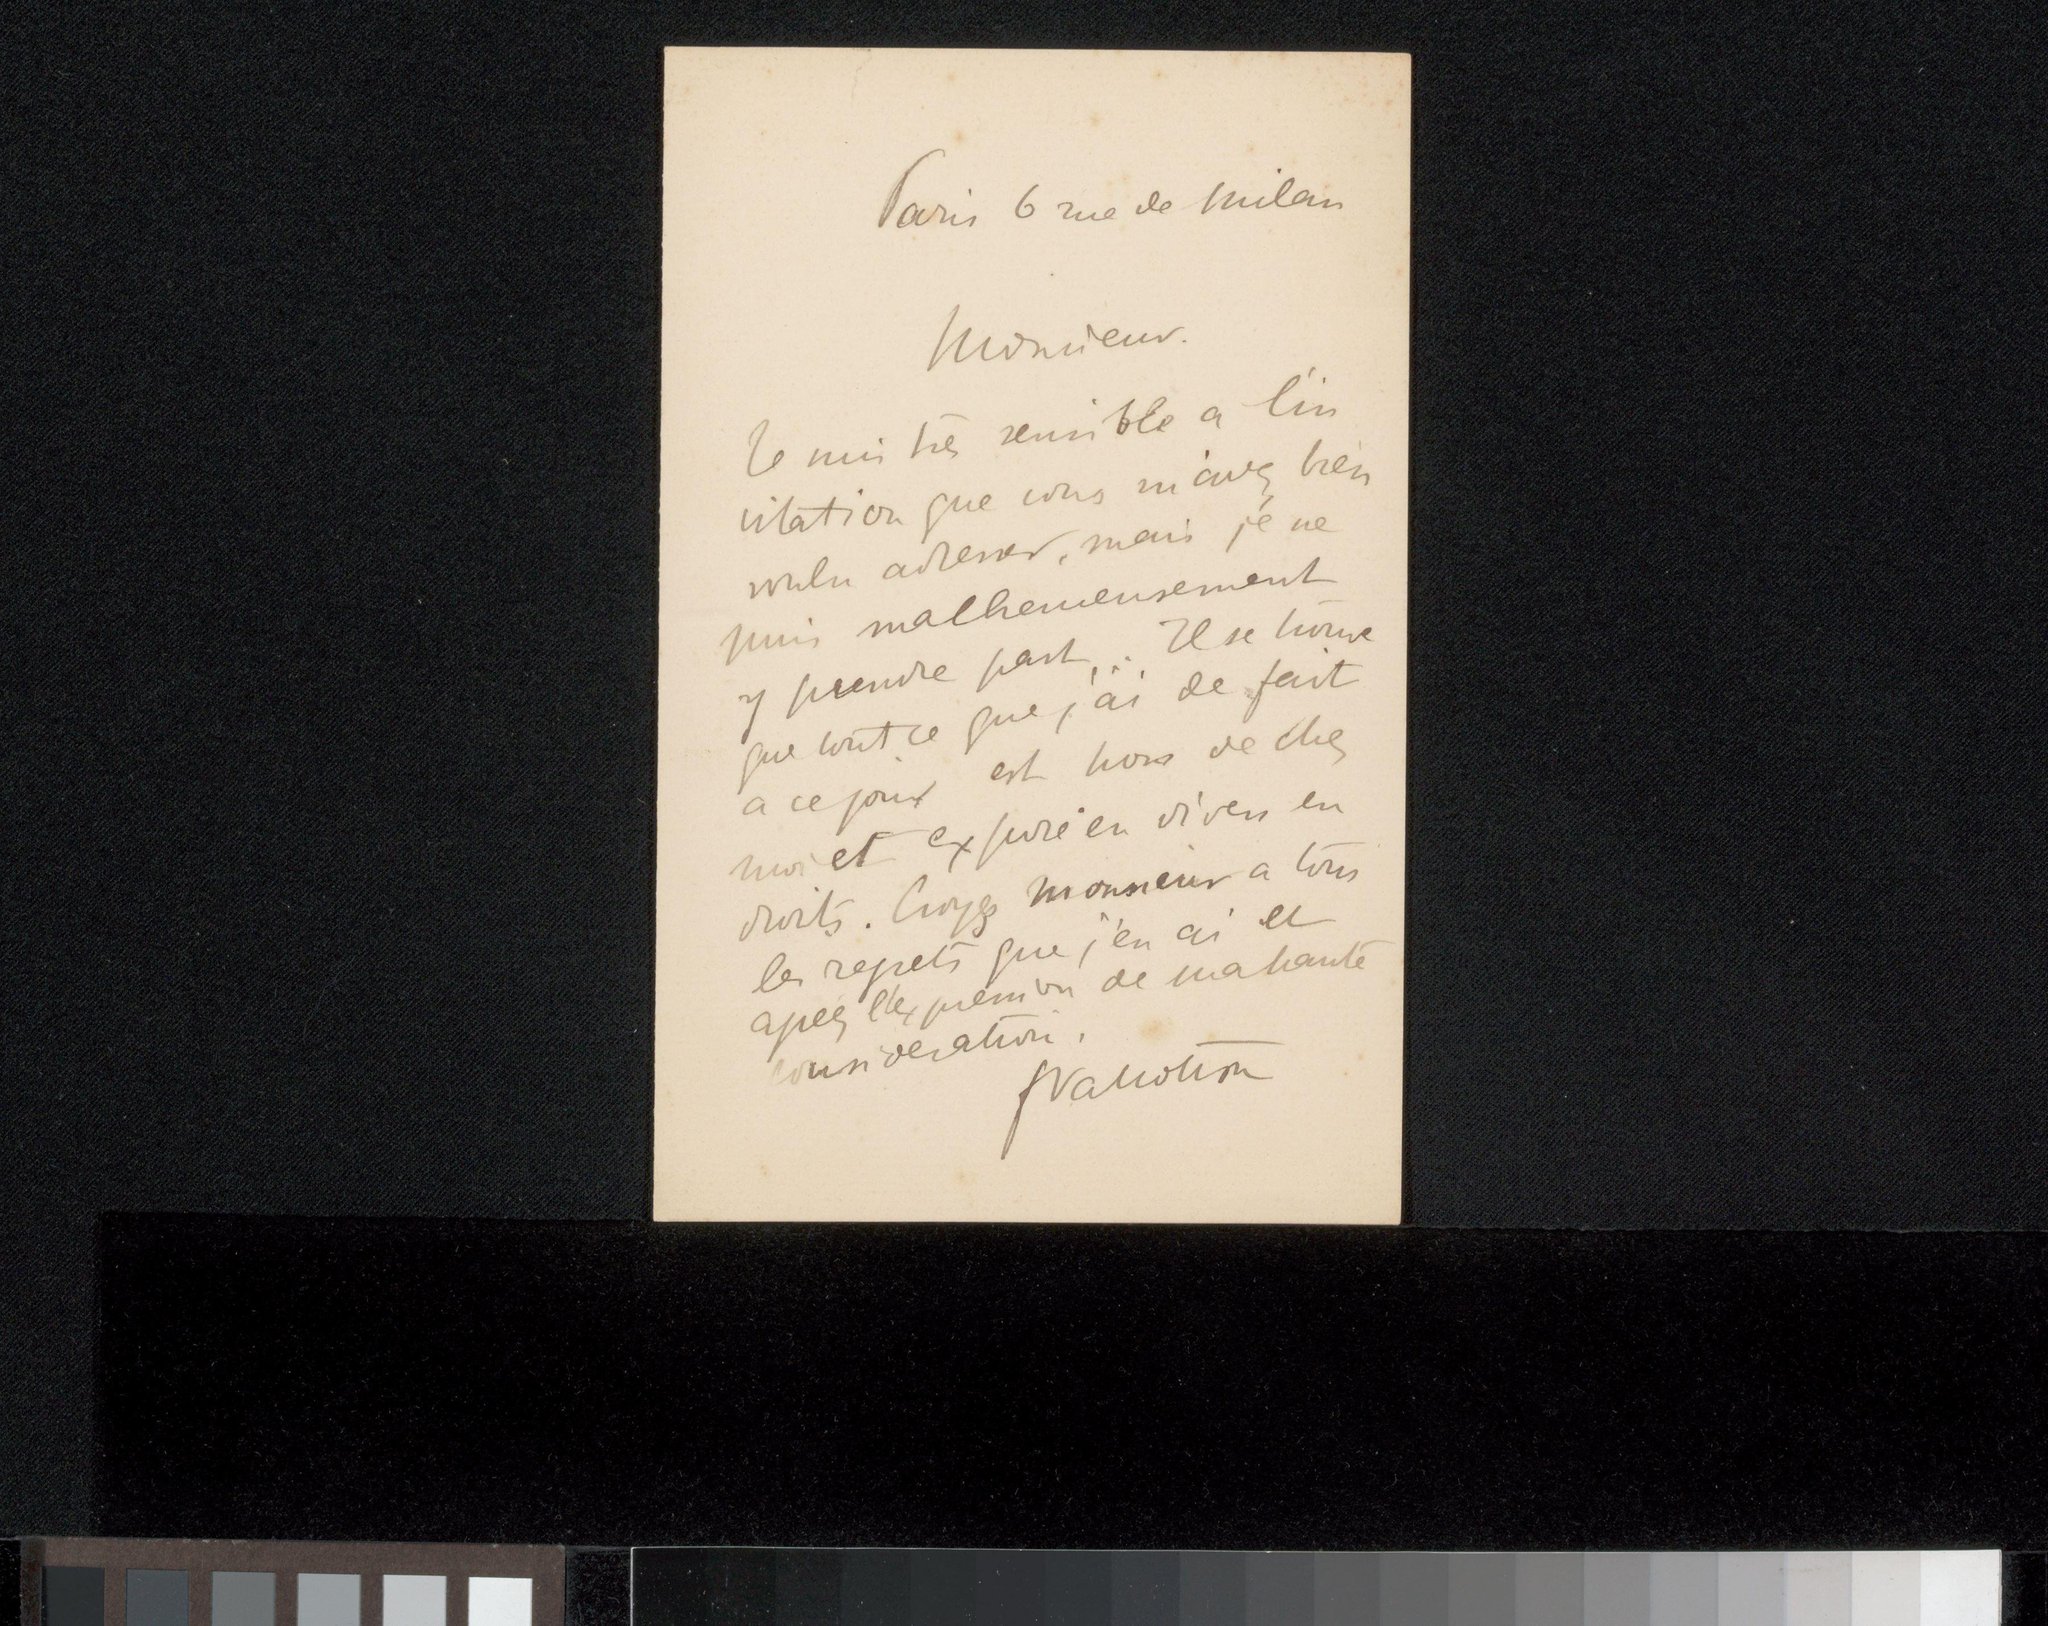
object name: letter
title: Brief aan Philip Zilcken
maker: félix edouard vallotton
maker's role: print maker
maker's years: 1865-1925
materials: ink, paper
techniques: pen, writing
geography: paris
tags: the hague, painter, draughtsman, philip zilcken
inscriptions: collector's mark: ‘RPK’, watermark